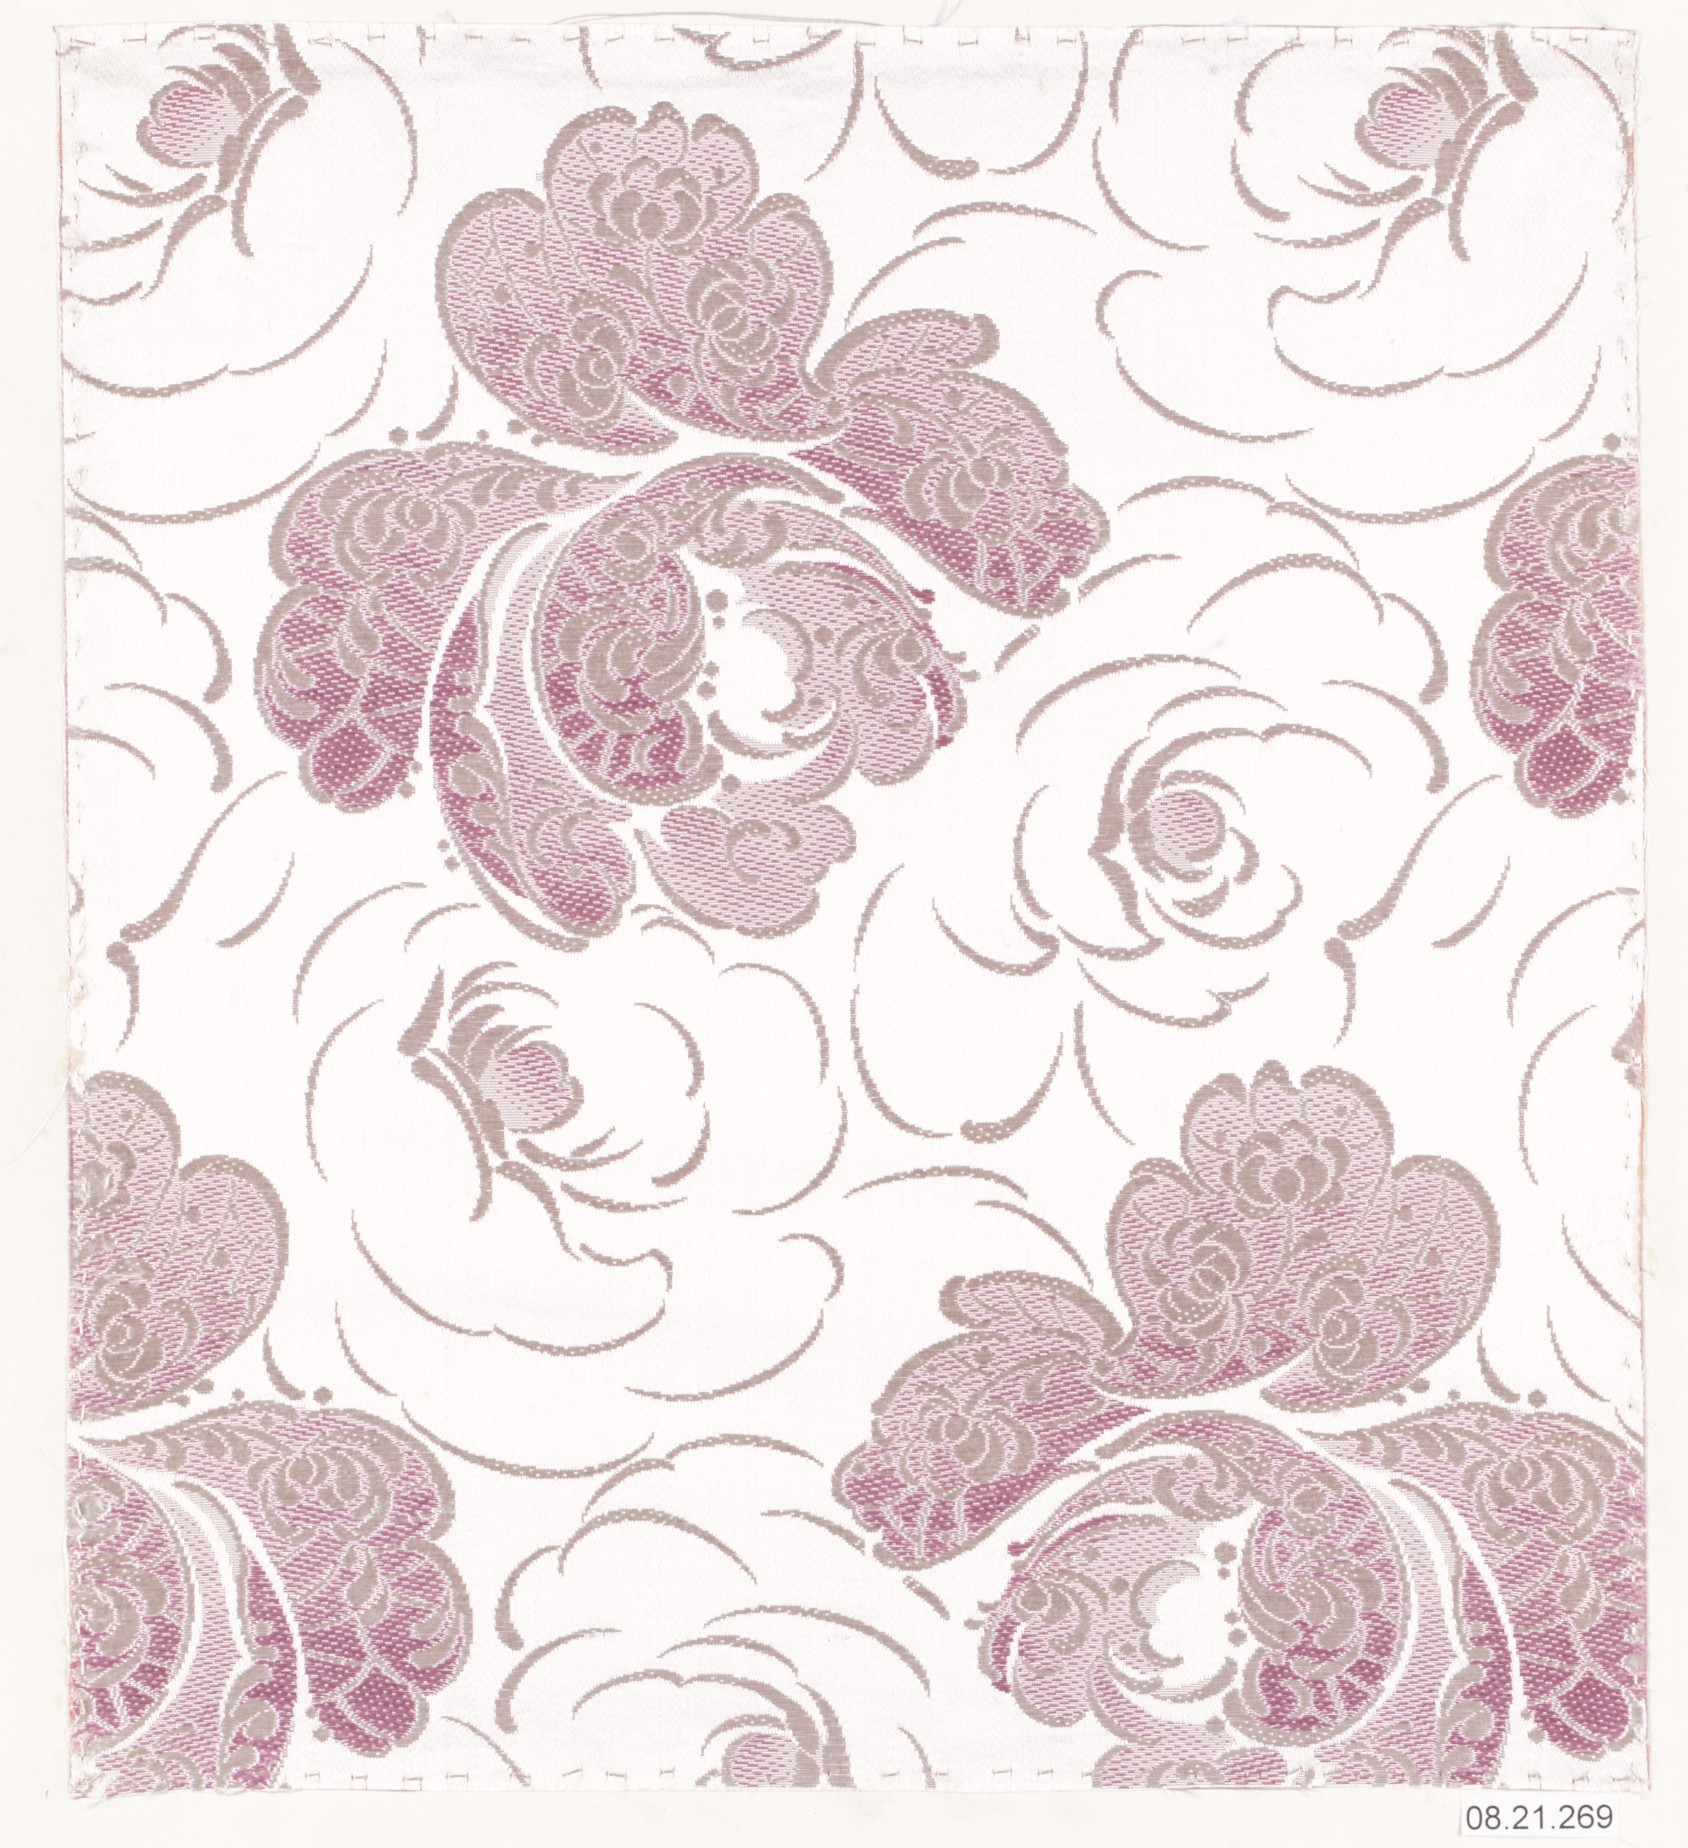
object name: textile sample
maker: Anonymous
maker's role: designer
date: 1900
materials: silk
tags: flowers